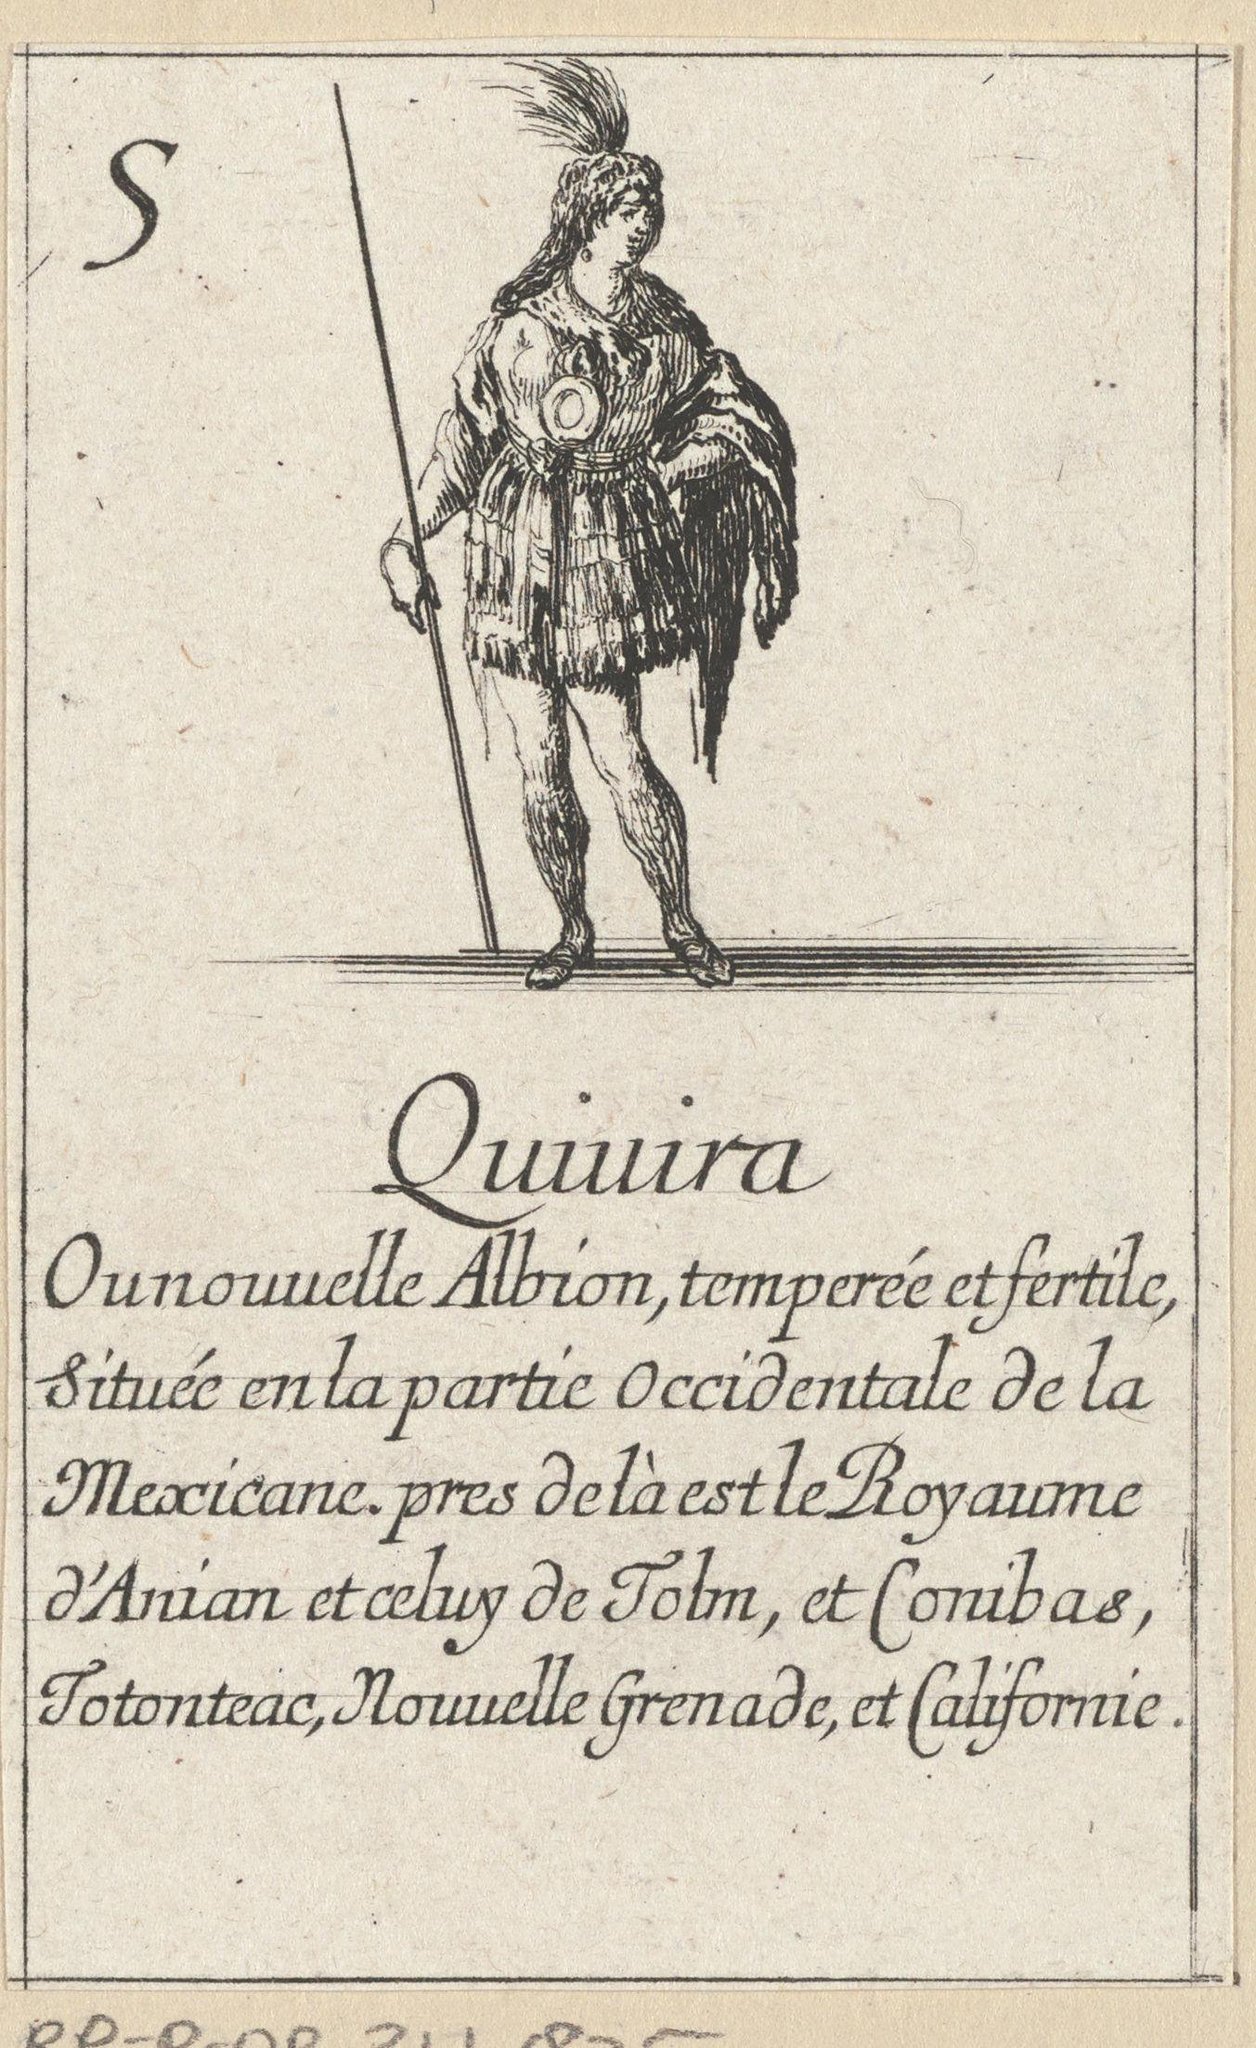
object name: print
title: Quiuira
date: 1620-1664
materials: paper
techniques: etching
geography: paris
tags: indigenous peoples of north america (+ costume)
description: Deze prent maakt deel uit van een kaartspel met 52 kaarten met voorstellingen van vrouwen uit landen over de hele wereld. De serie is uitgedacht door Jean Desmarests de Saint-Sorlin in opdracht van Kardinaal Mazarin. Het kaartspel werd gemaakt voor de jonge Lodewijk XIV, samen met het Jeu des Fables, Jeu des Reynes Renommées en Jeu des Rois de France.